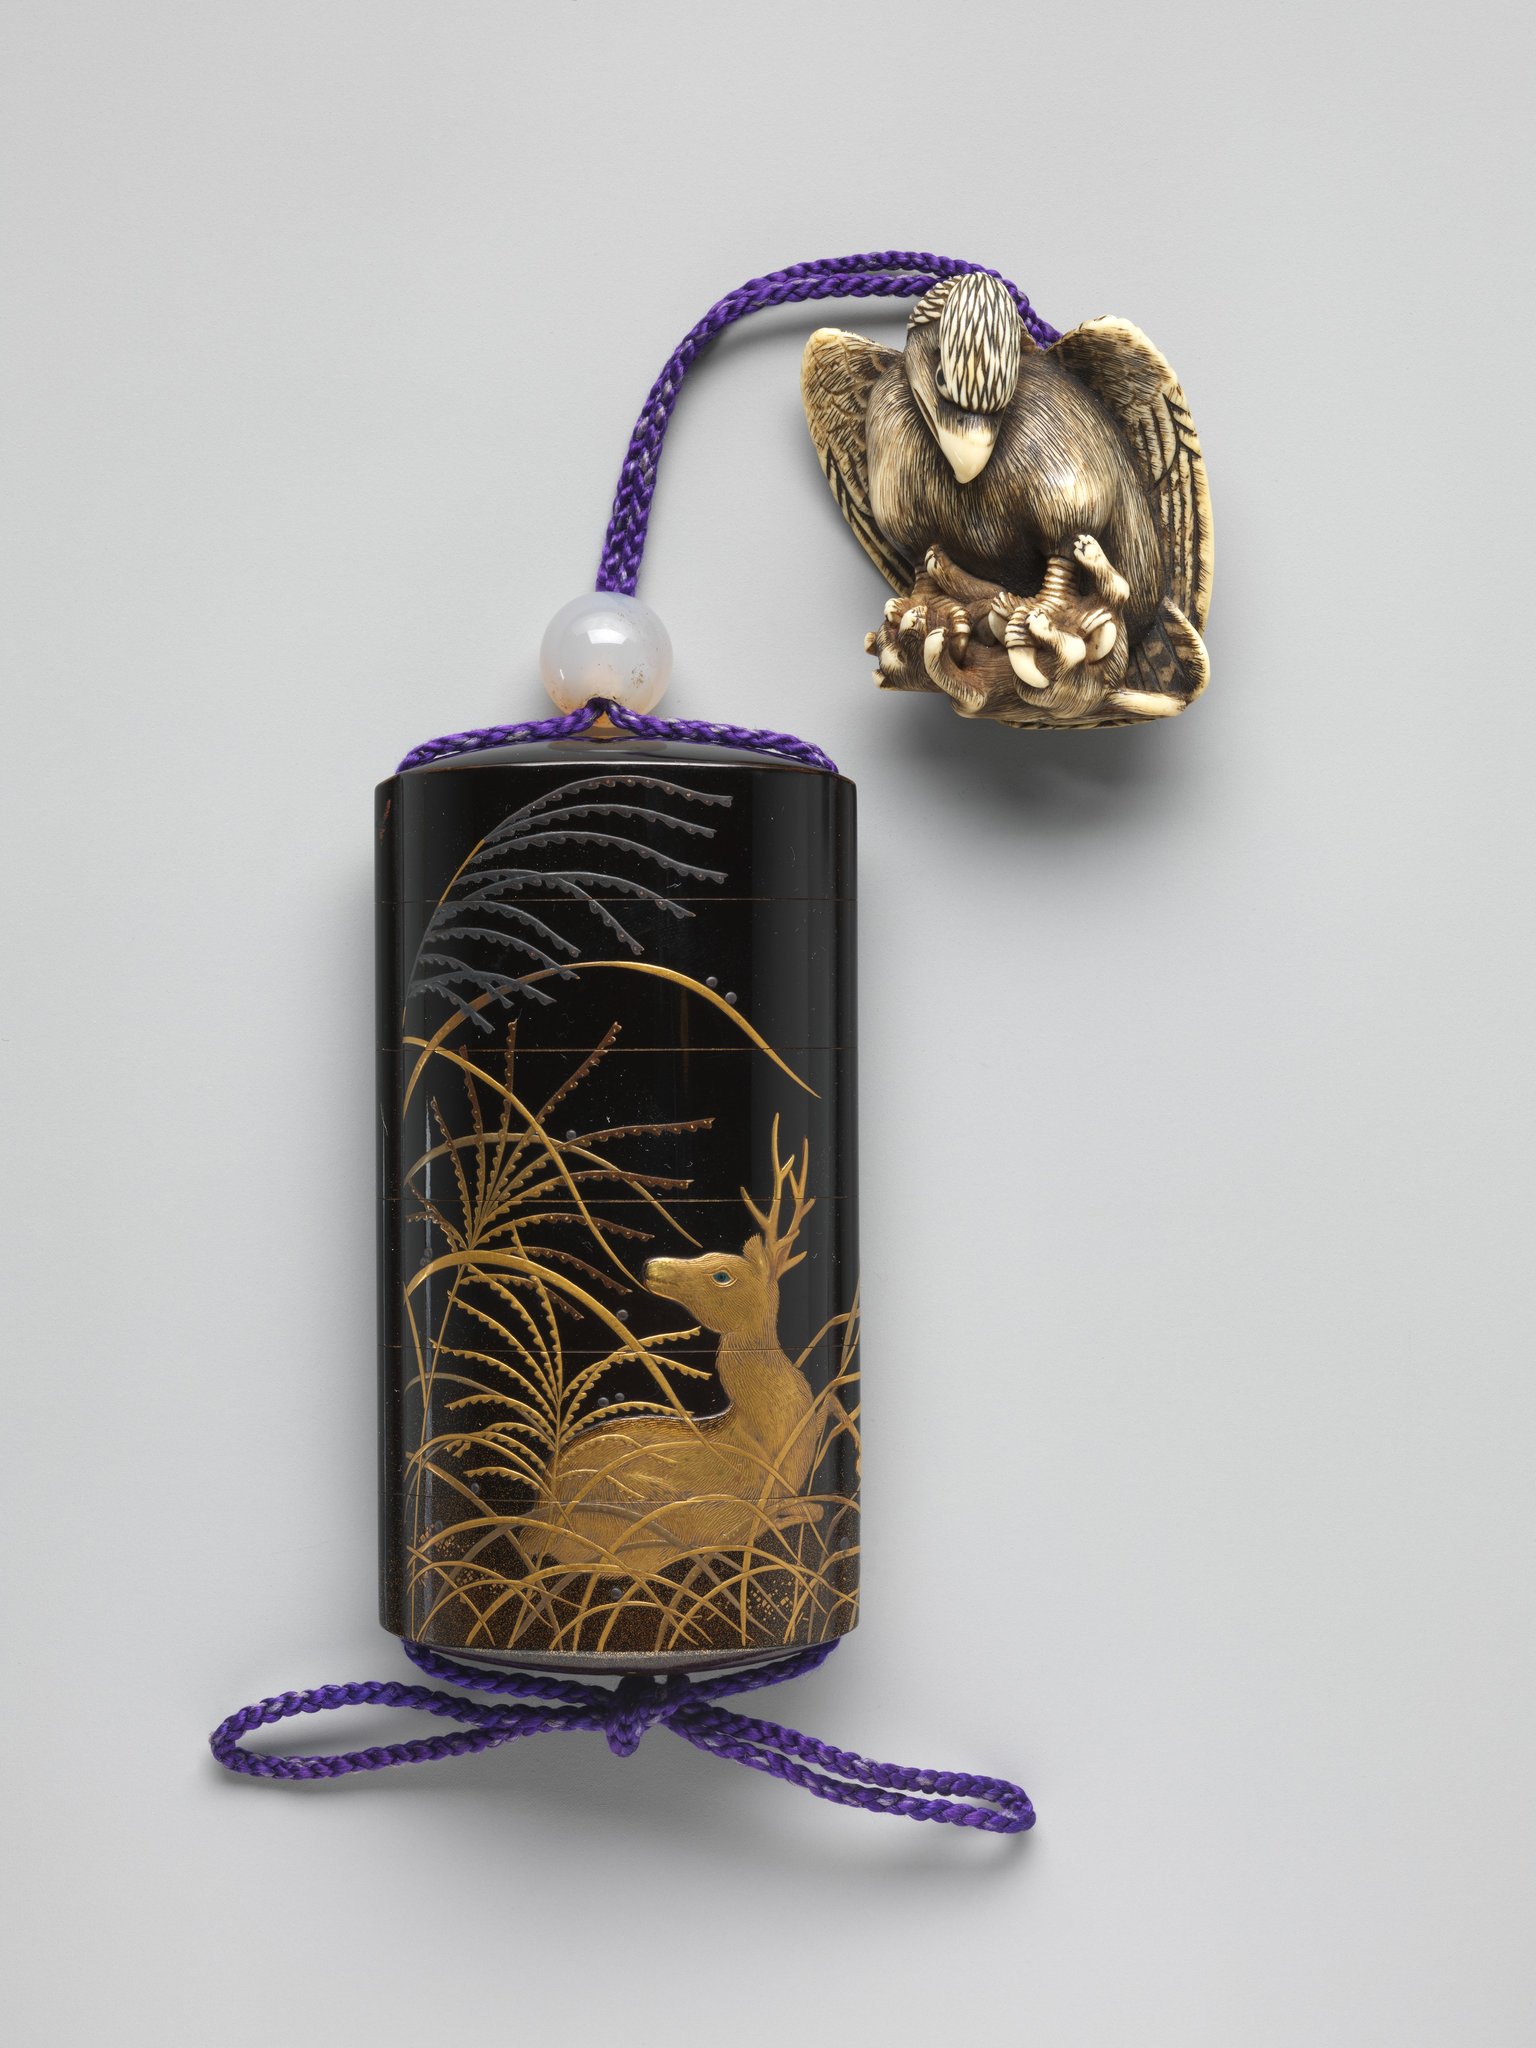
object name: inrō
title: Case (Inrō) with Design of Eulalia Grass and Deer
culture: japanese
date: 1801-1900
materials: stone, gold, gold foil, ivory, lacquer, shell, silver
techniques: carving, inlay, maki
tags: eagles,deer,plants